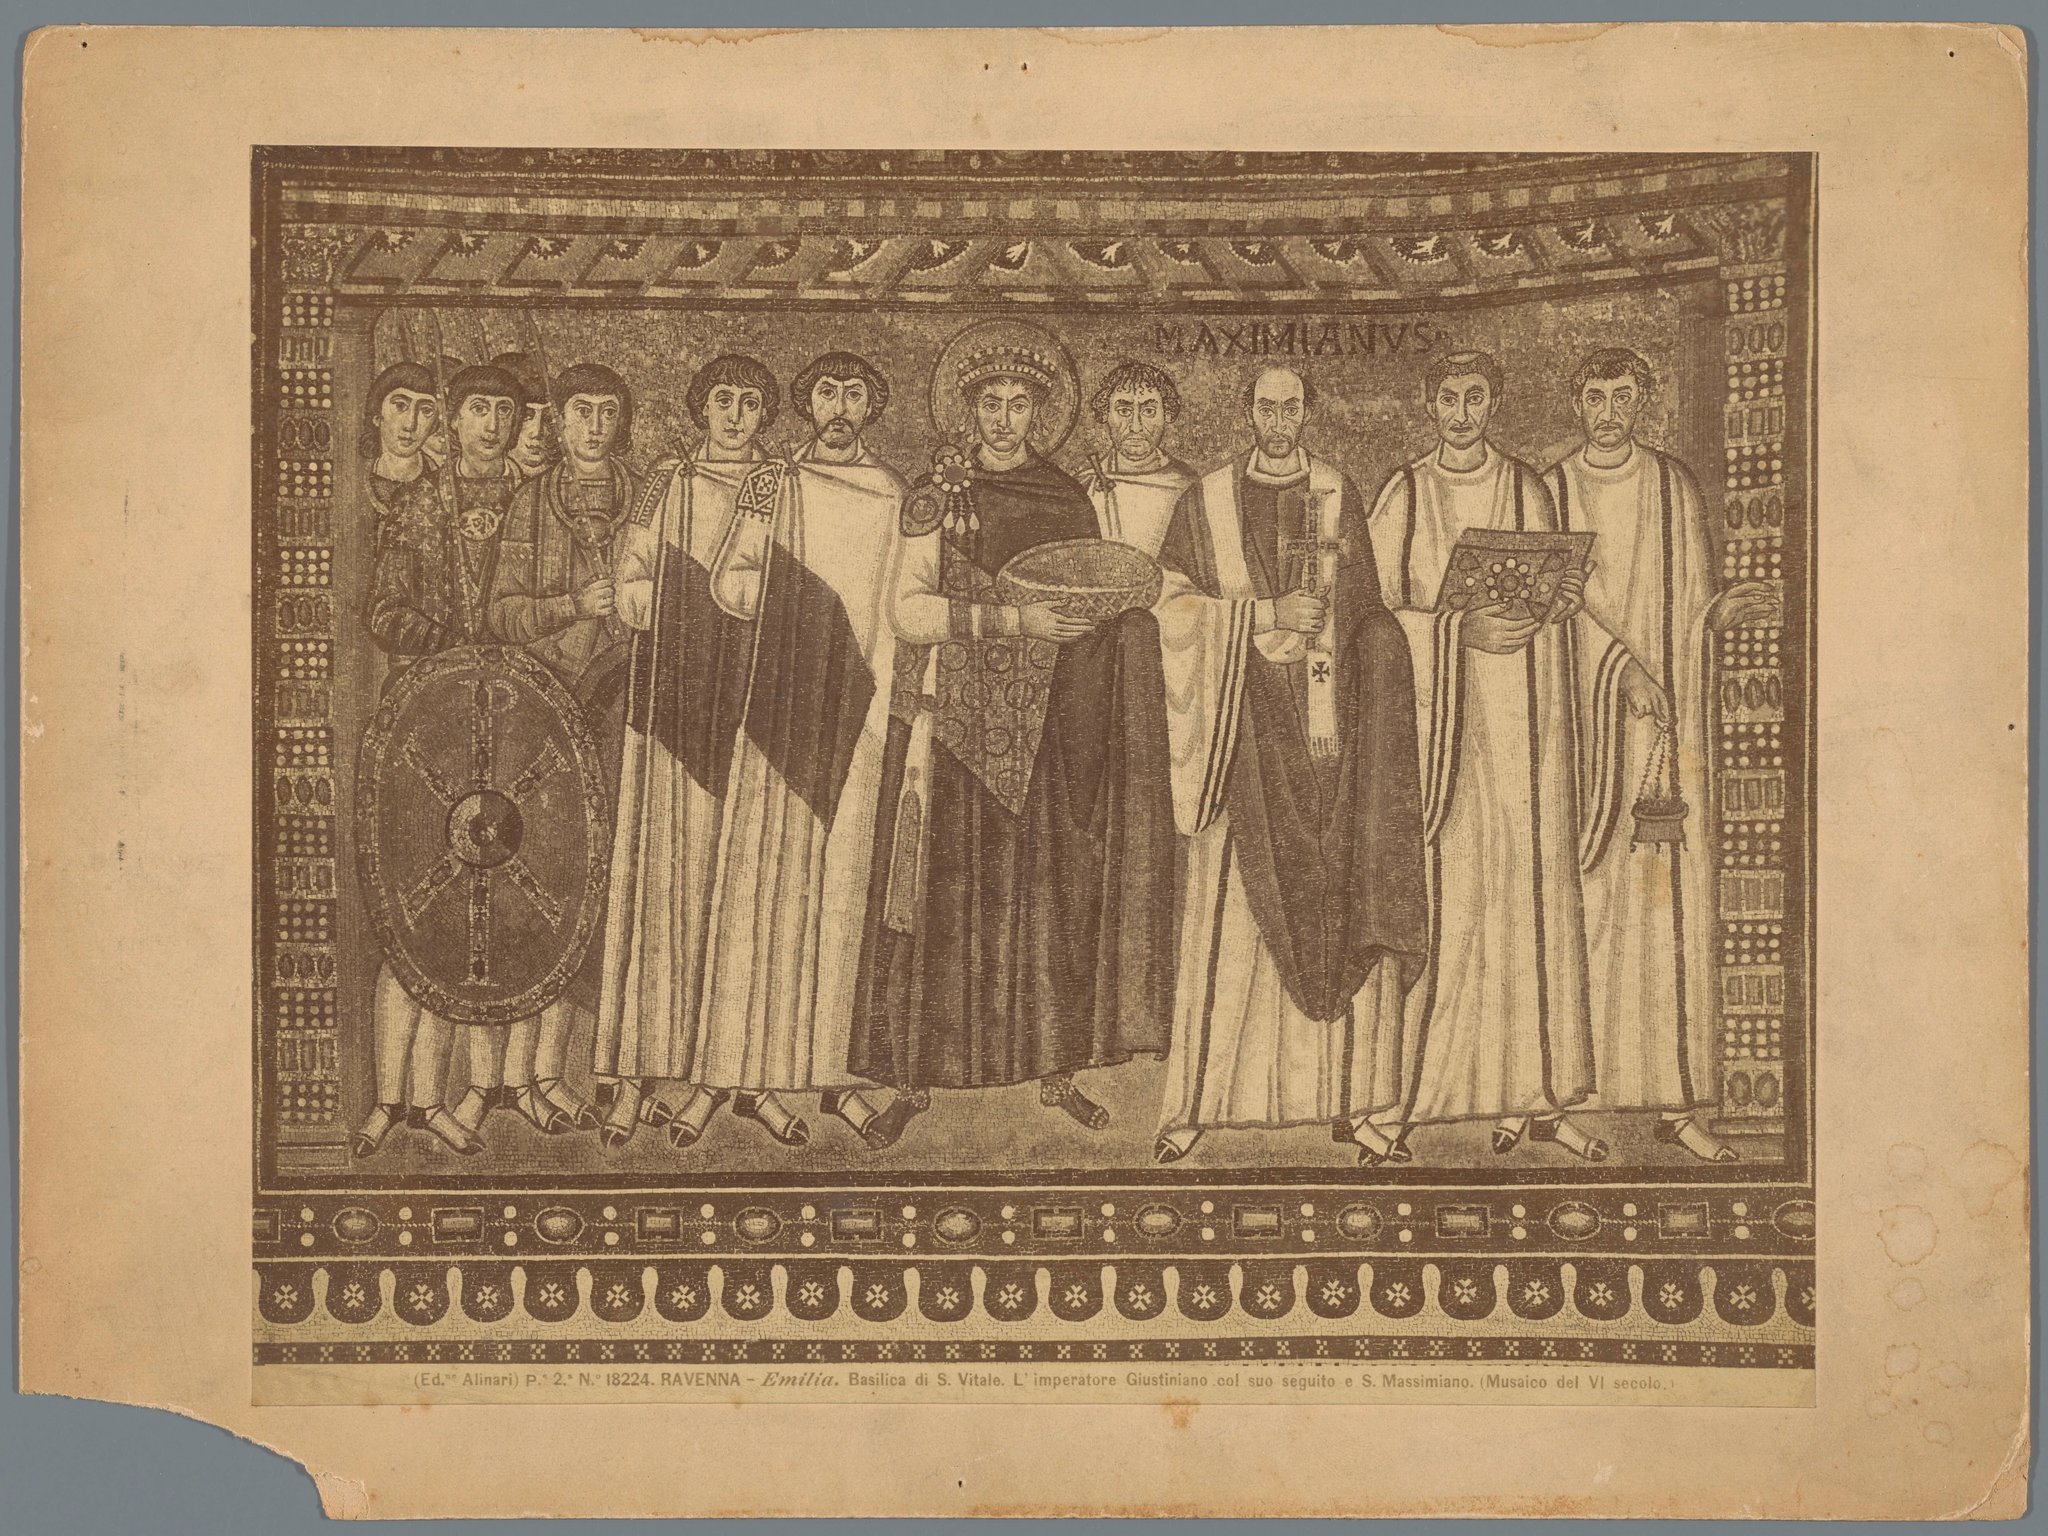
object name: photograph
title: Mozaïek in de Basilica di San Vitale te Ravenna, voorstellende keizer Justinianus en de heilige Maximianus van Ravenna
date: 1875-1900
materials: cardboard, photographic support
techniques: albumen print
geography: basilica di san vitale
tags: art (+ mosaic making), saints, emperor, parts of church interior: choir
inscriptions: number: ‘P.e 2.a N.o 18224.’, collector's mark: Lugt 3937